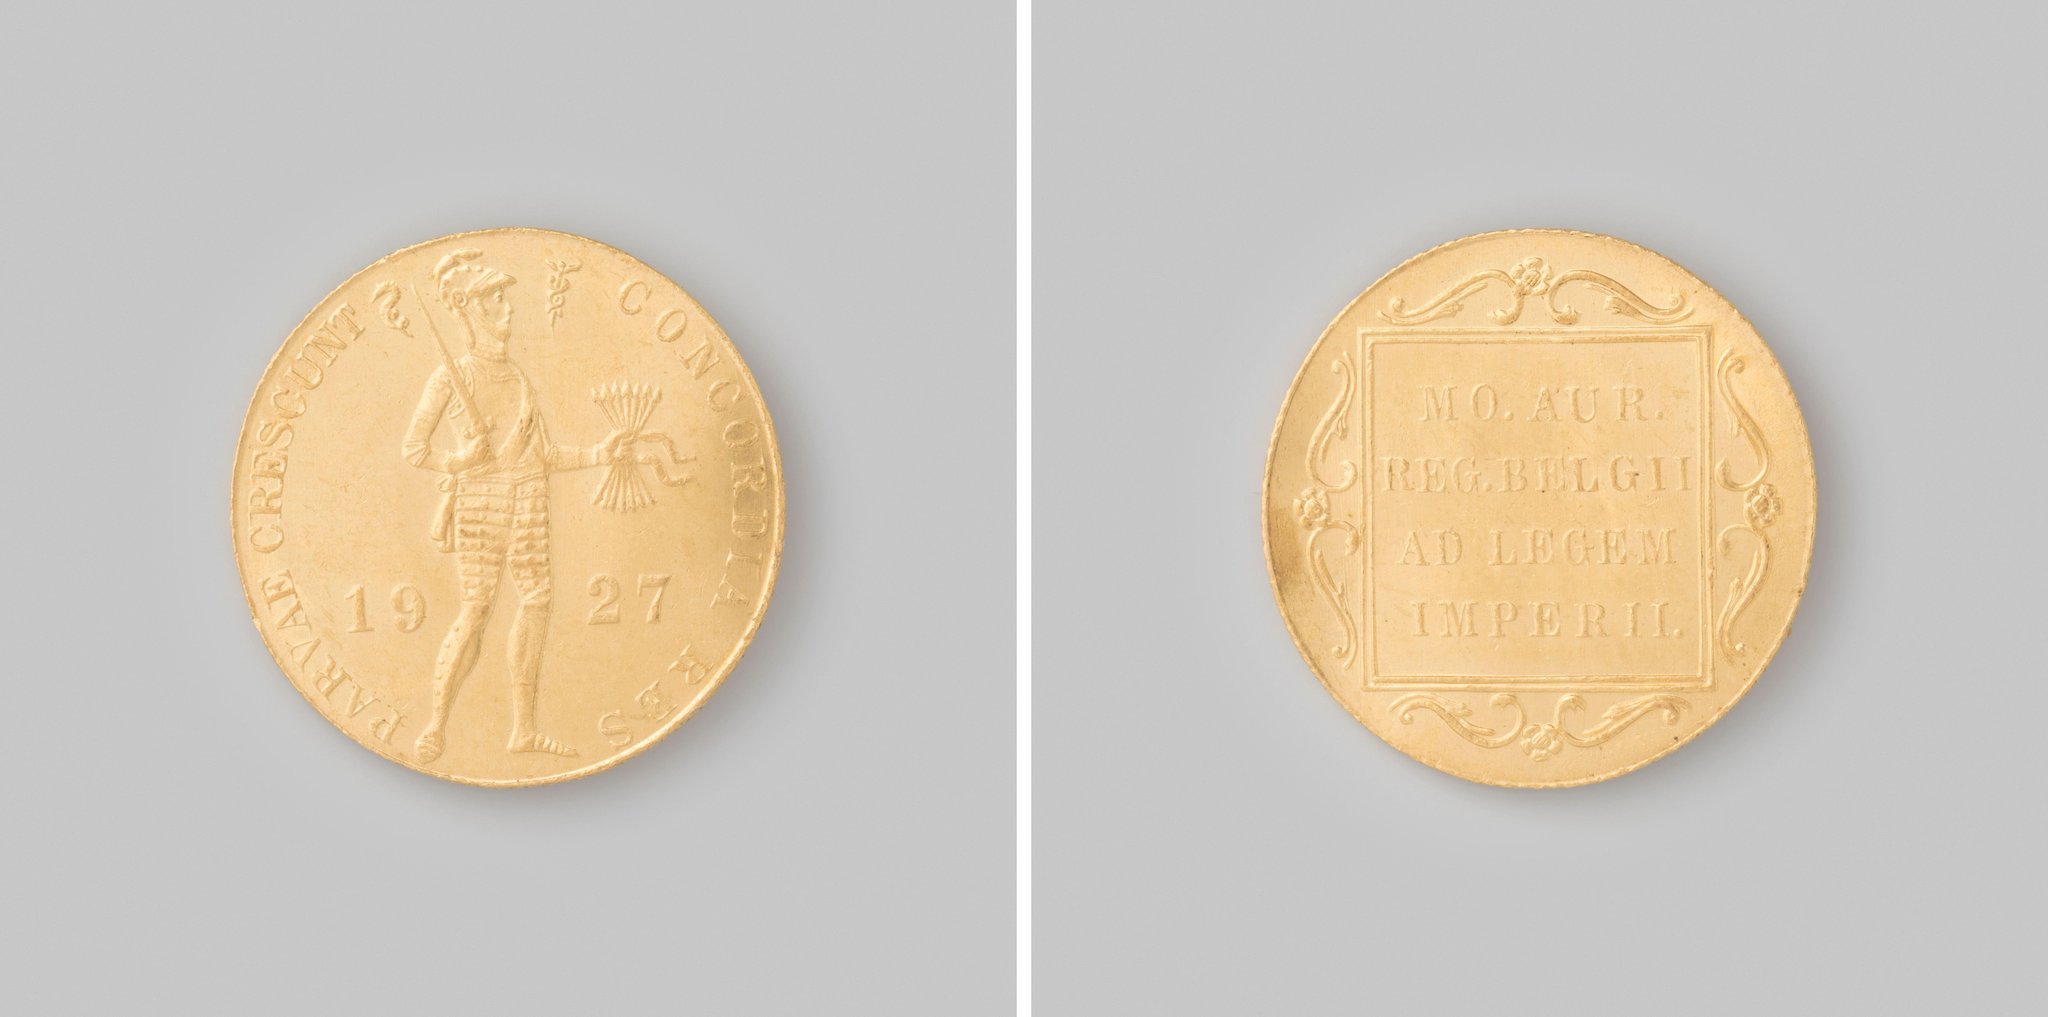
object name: gouden dukaat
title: Nederland,dukaat, 1927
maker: wilhelmina of the netherlands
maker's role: print maker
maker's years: 1880-1962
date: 1927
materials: gold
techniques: striking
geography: utrecht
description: Gouden munt. Voorzijde: tussen jaartal staande ridder met zwaard en pijlenbundel. Keerzijde: in een versierd vierkant vier-regelig opschrift. Kabelrand.